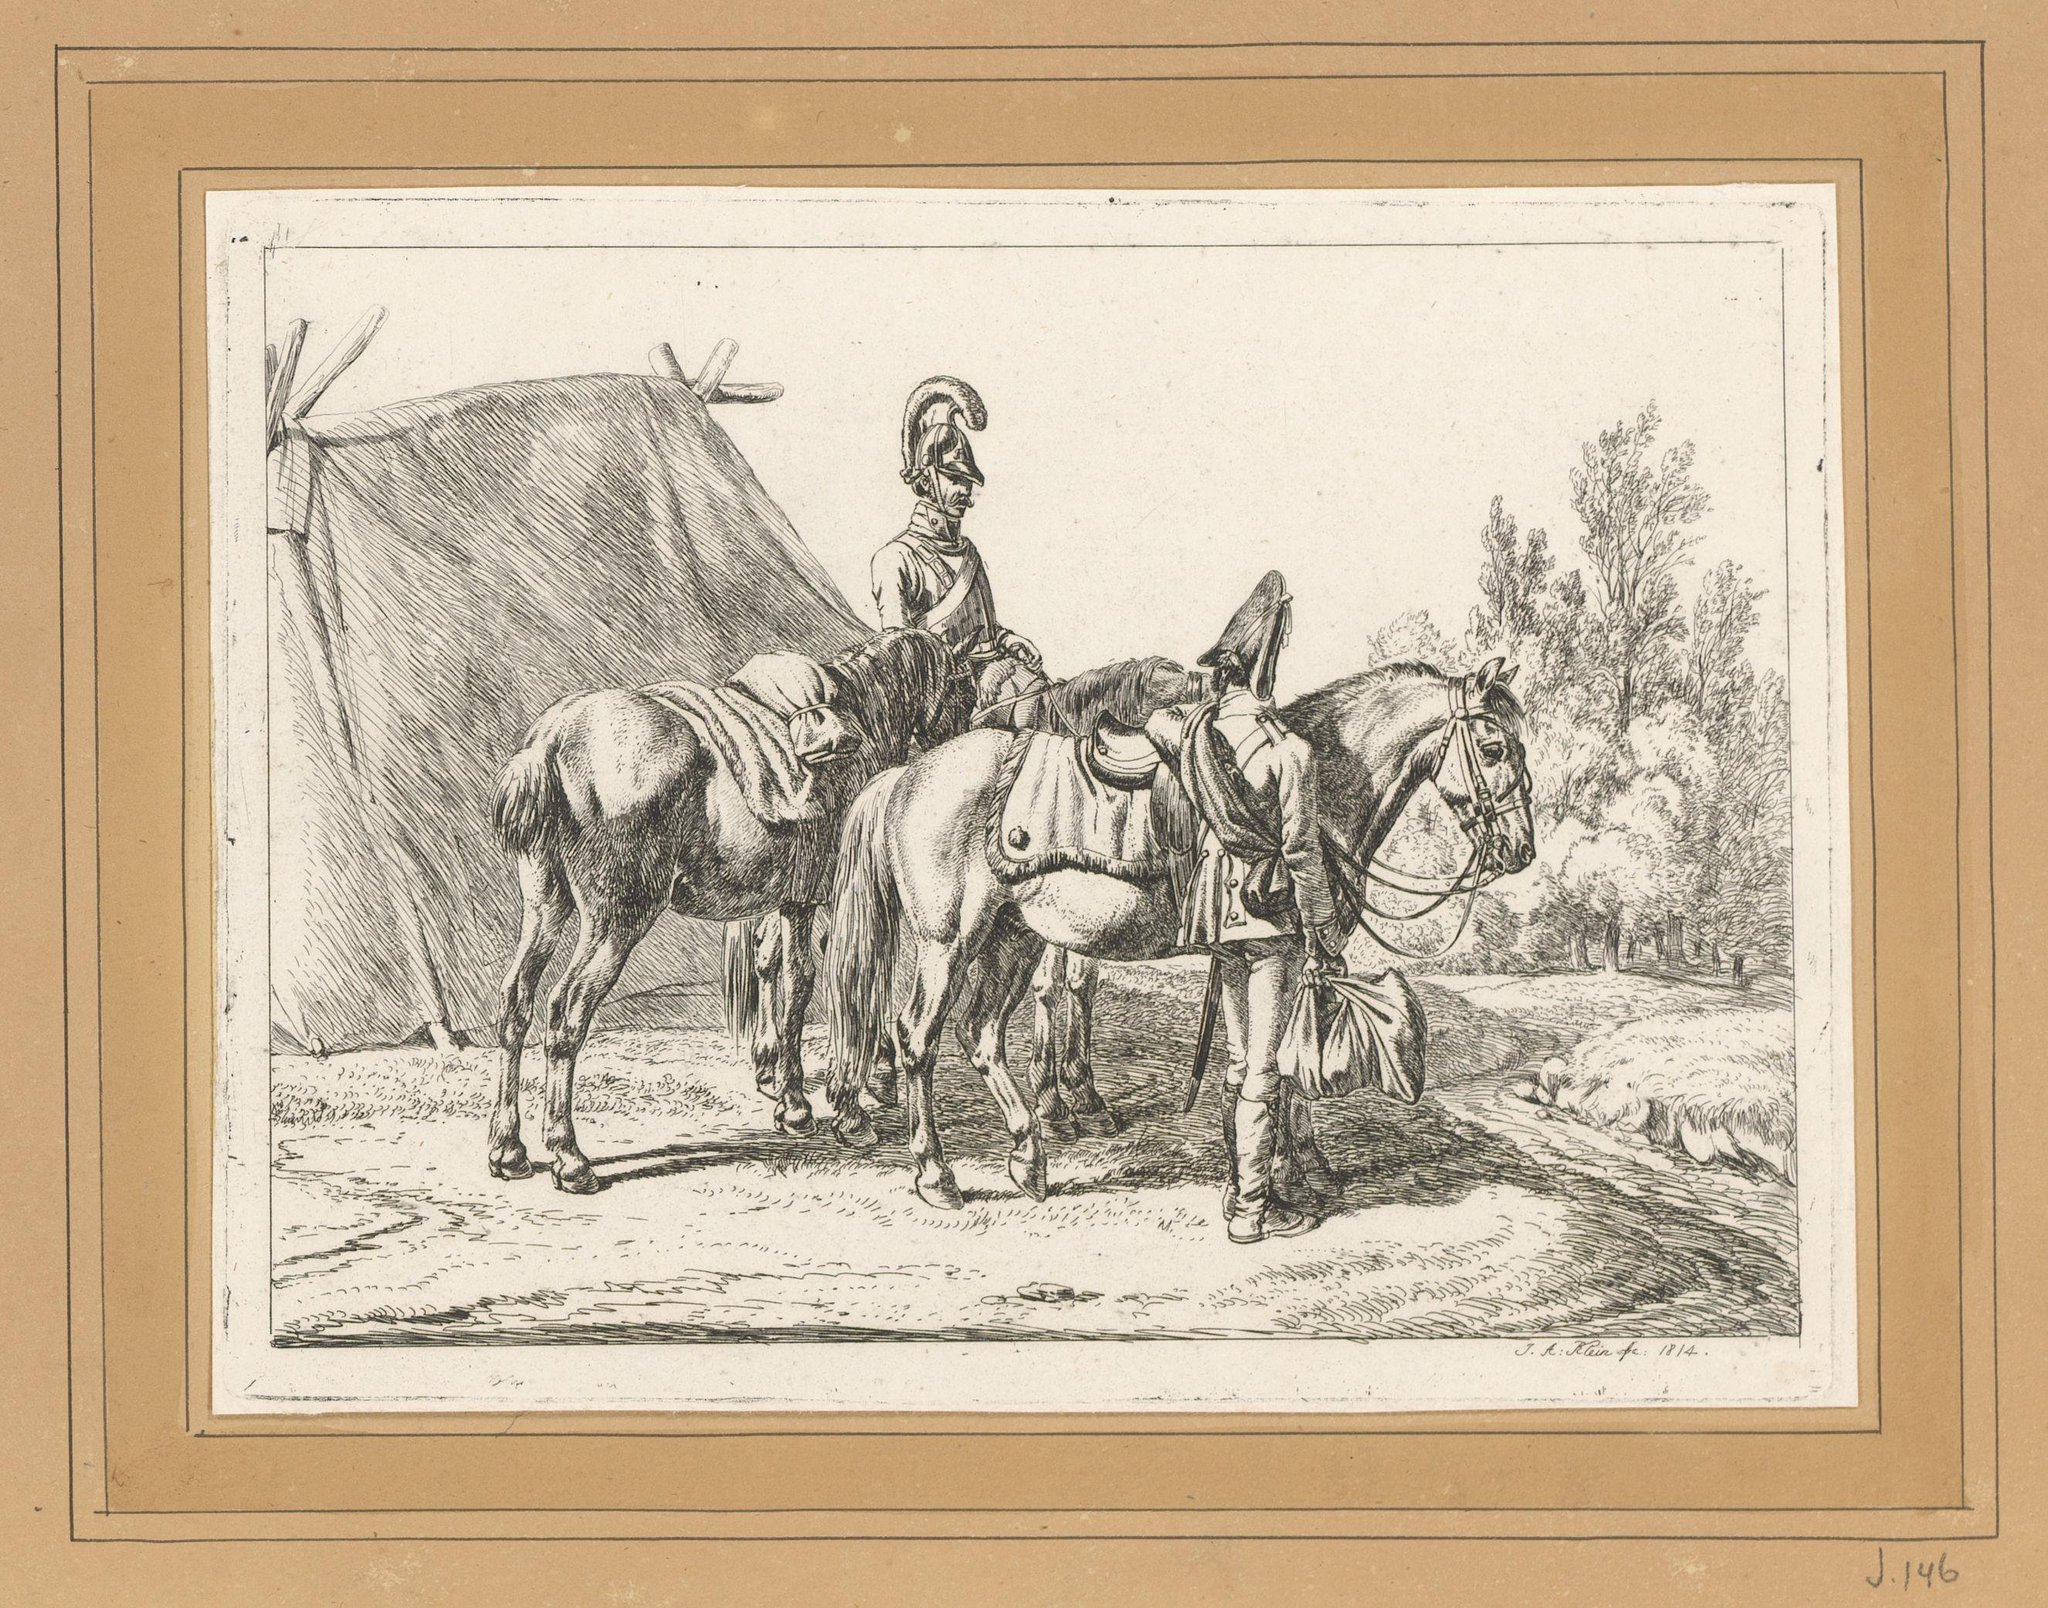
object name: print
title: Twee kurassiers met drie paarden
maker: johann adam klein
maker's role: draughtsman, print maker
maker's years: 1792-1875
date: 1814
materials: paper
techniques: etching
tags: the soldier; the soldier's life, horse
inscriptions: collector's mark: Lugt 2228, : Lugt 2760